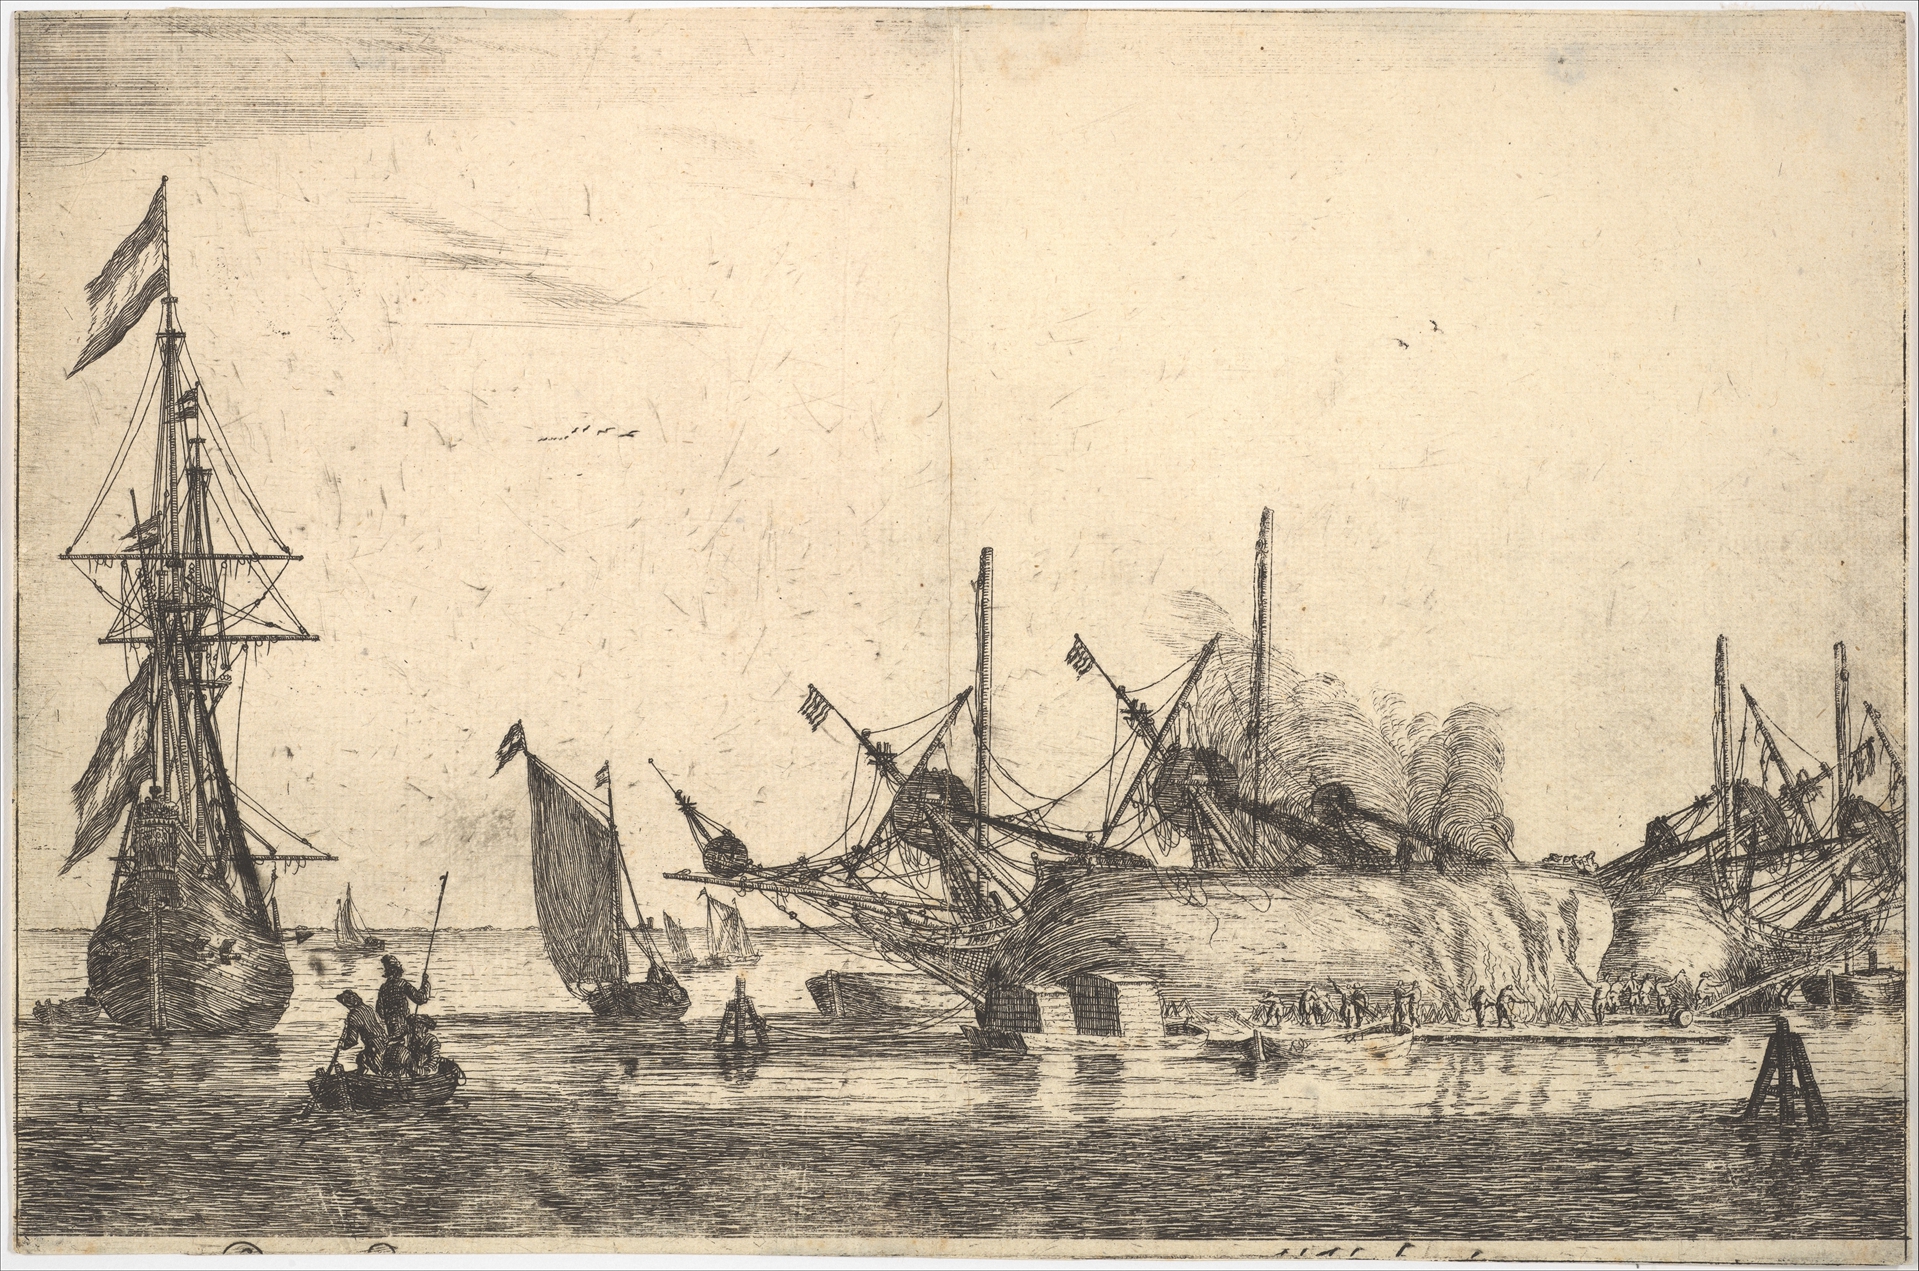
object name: print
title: Ships Careened for Caulking the Hull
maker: reinier nooms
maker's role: artist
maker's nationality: dutch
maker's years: 1623-1664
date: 1601-1700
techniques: etching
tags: ships